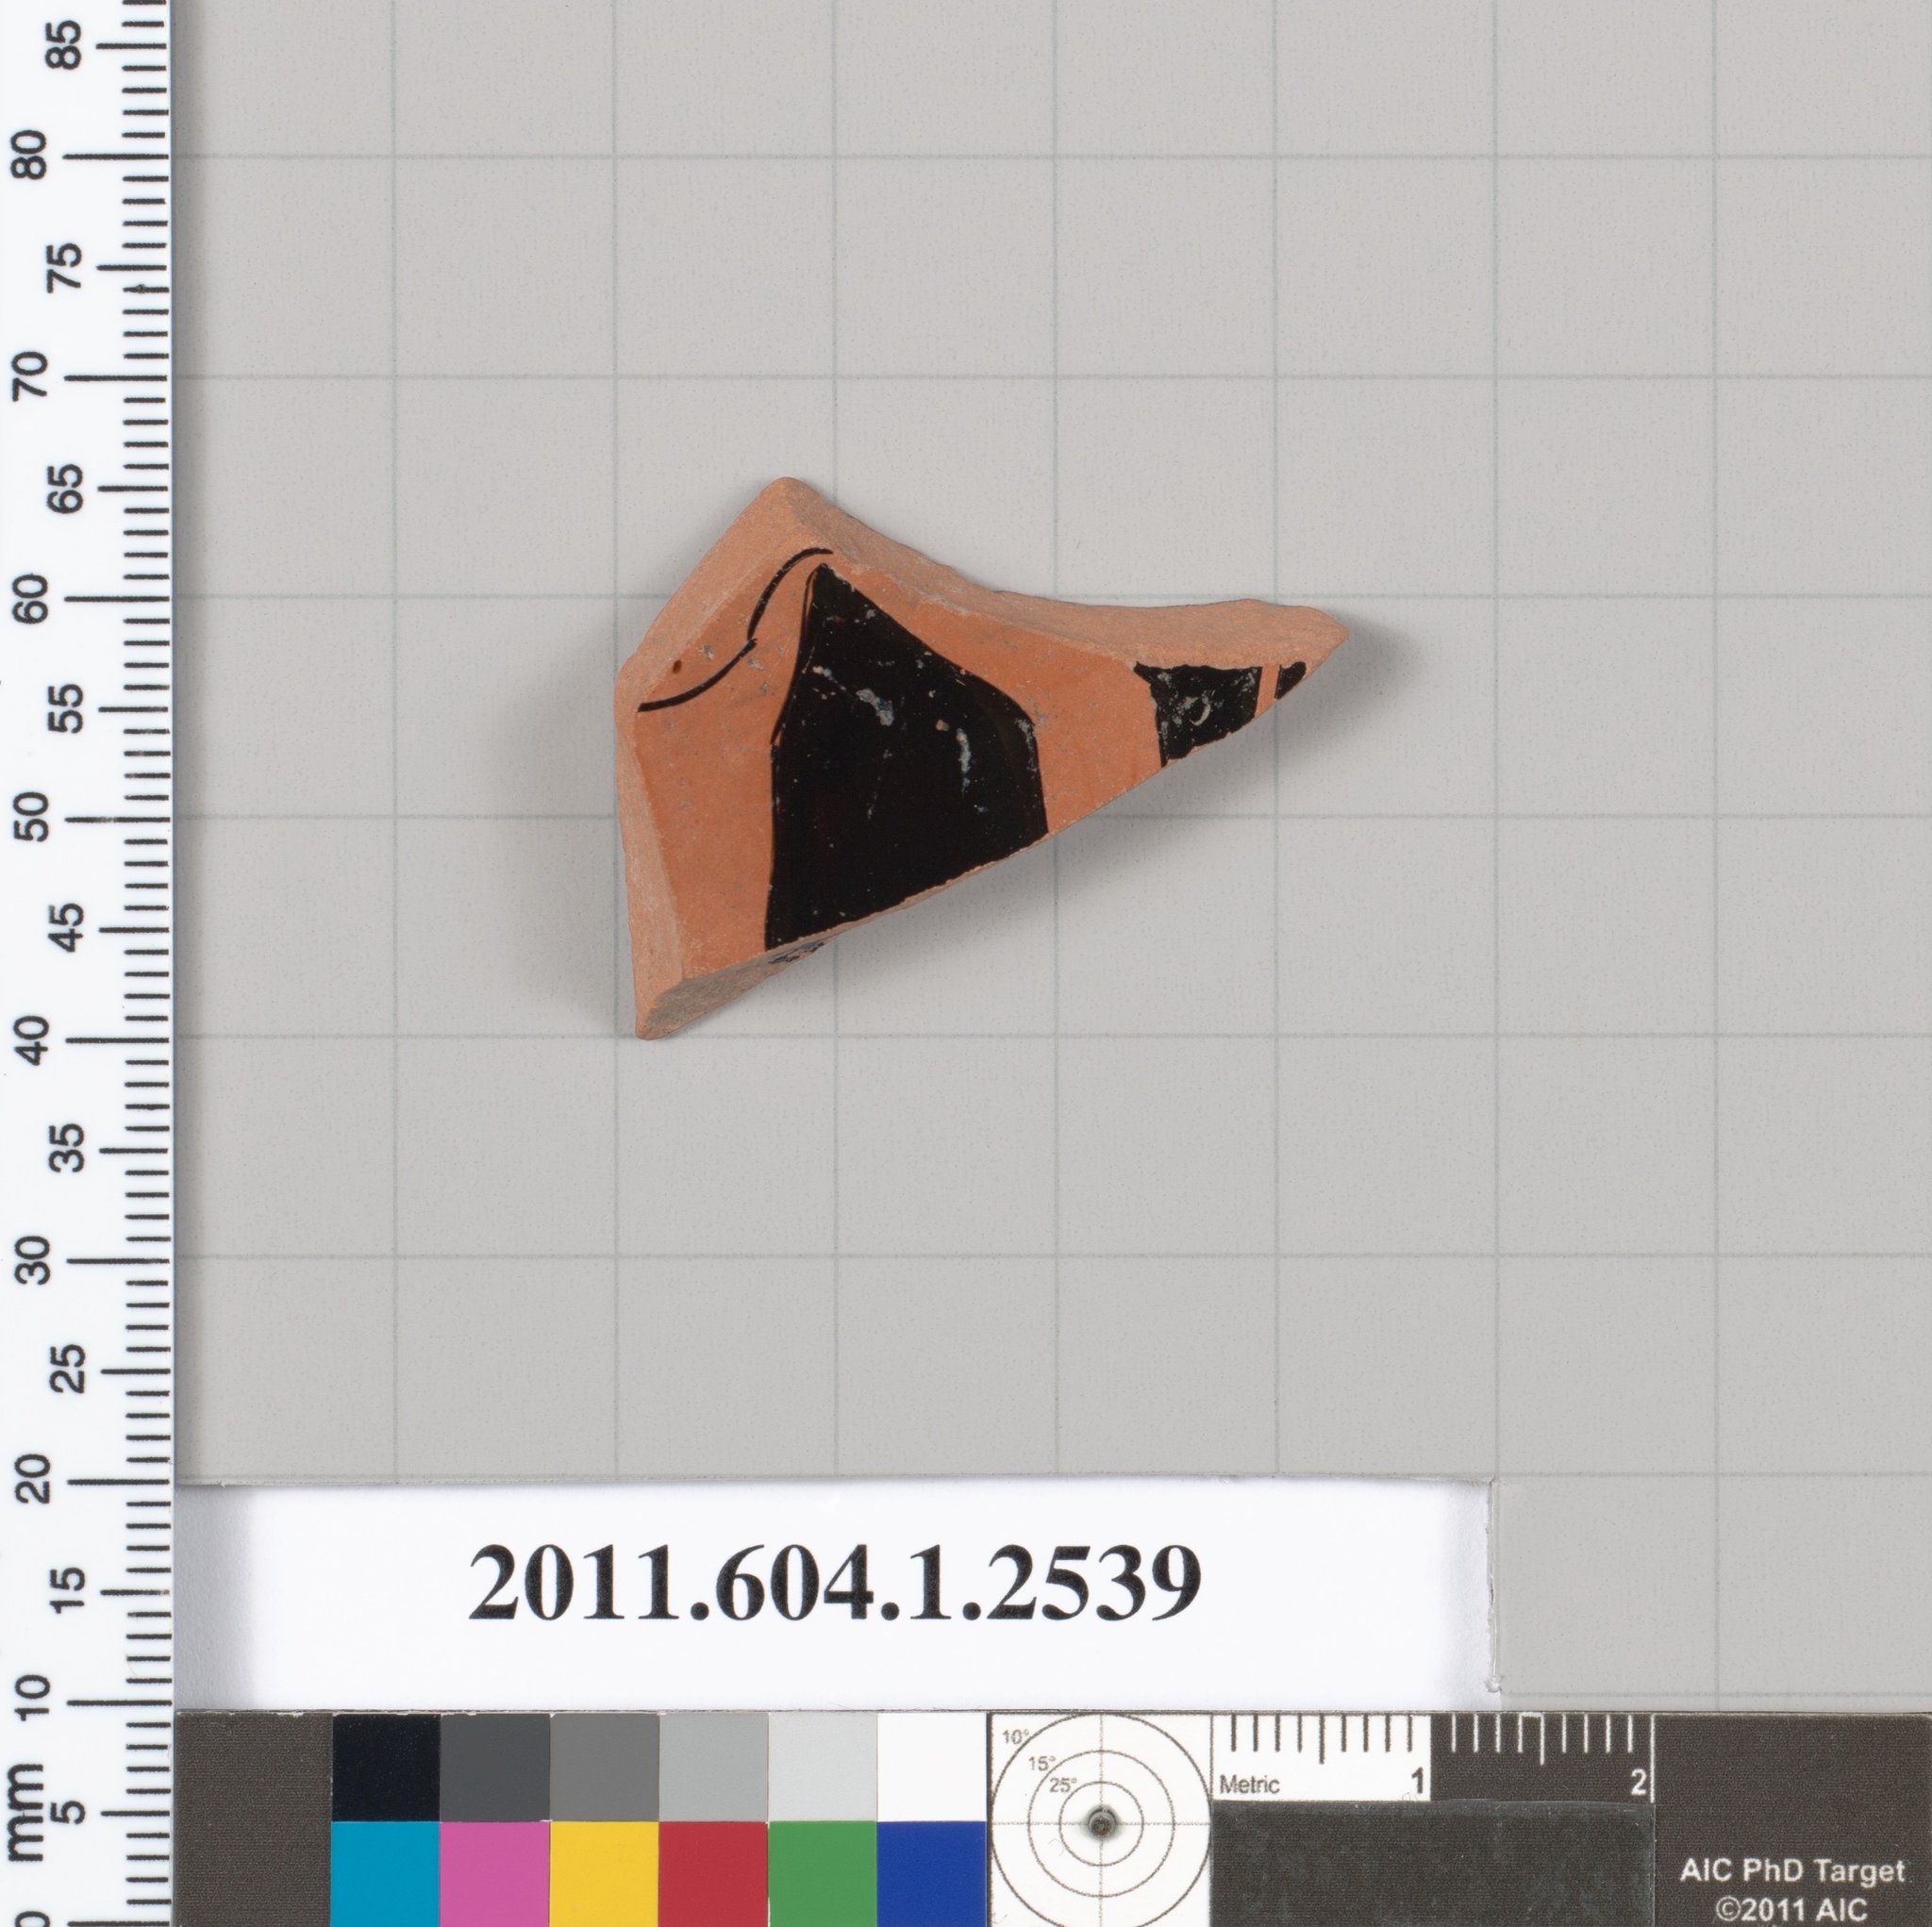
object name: kylix fragment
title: Terracotta fragment of a kylix (drinking cup)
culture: greek, attic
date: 490-480 BCE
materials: terracotta